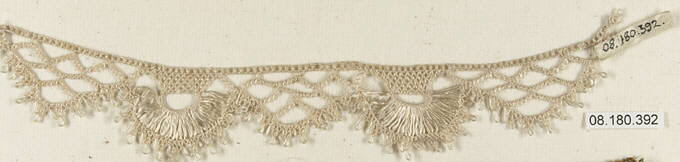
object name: fragment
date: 1801-1900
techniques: lace